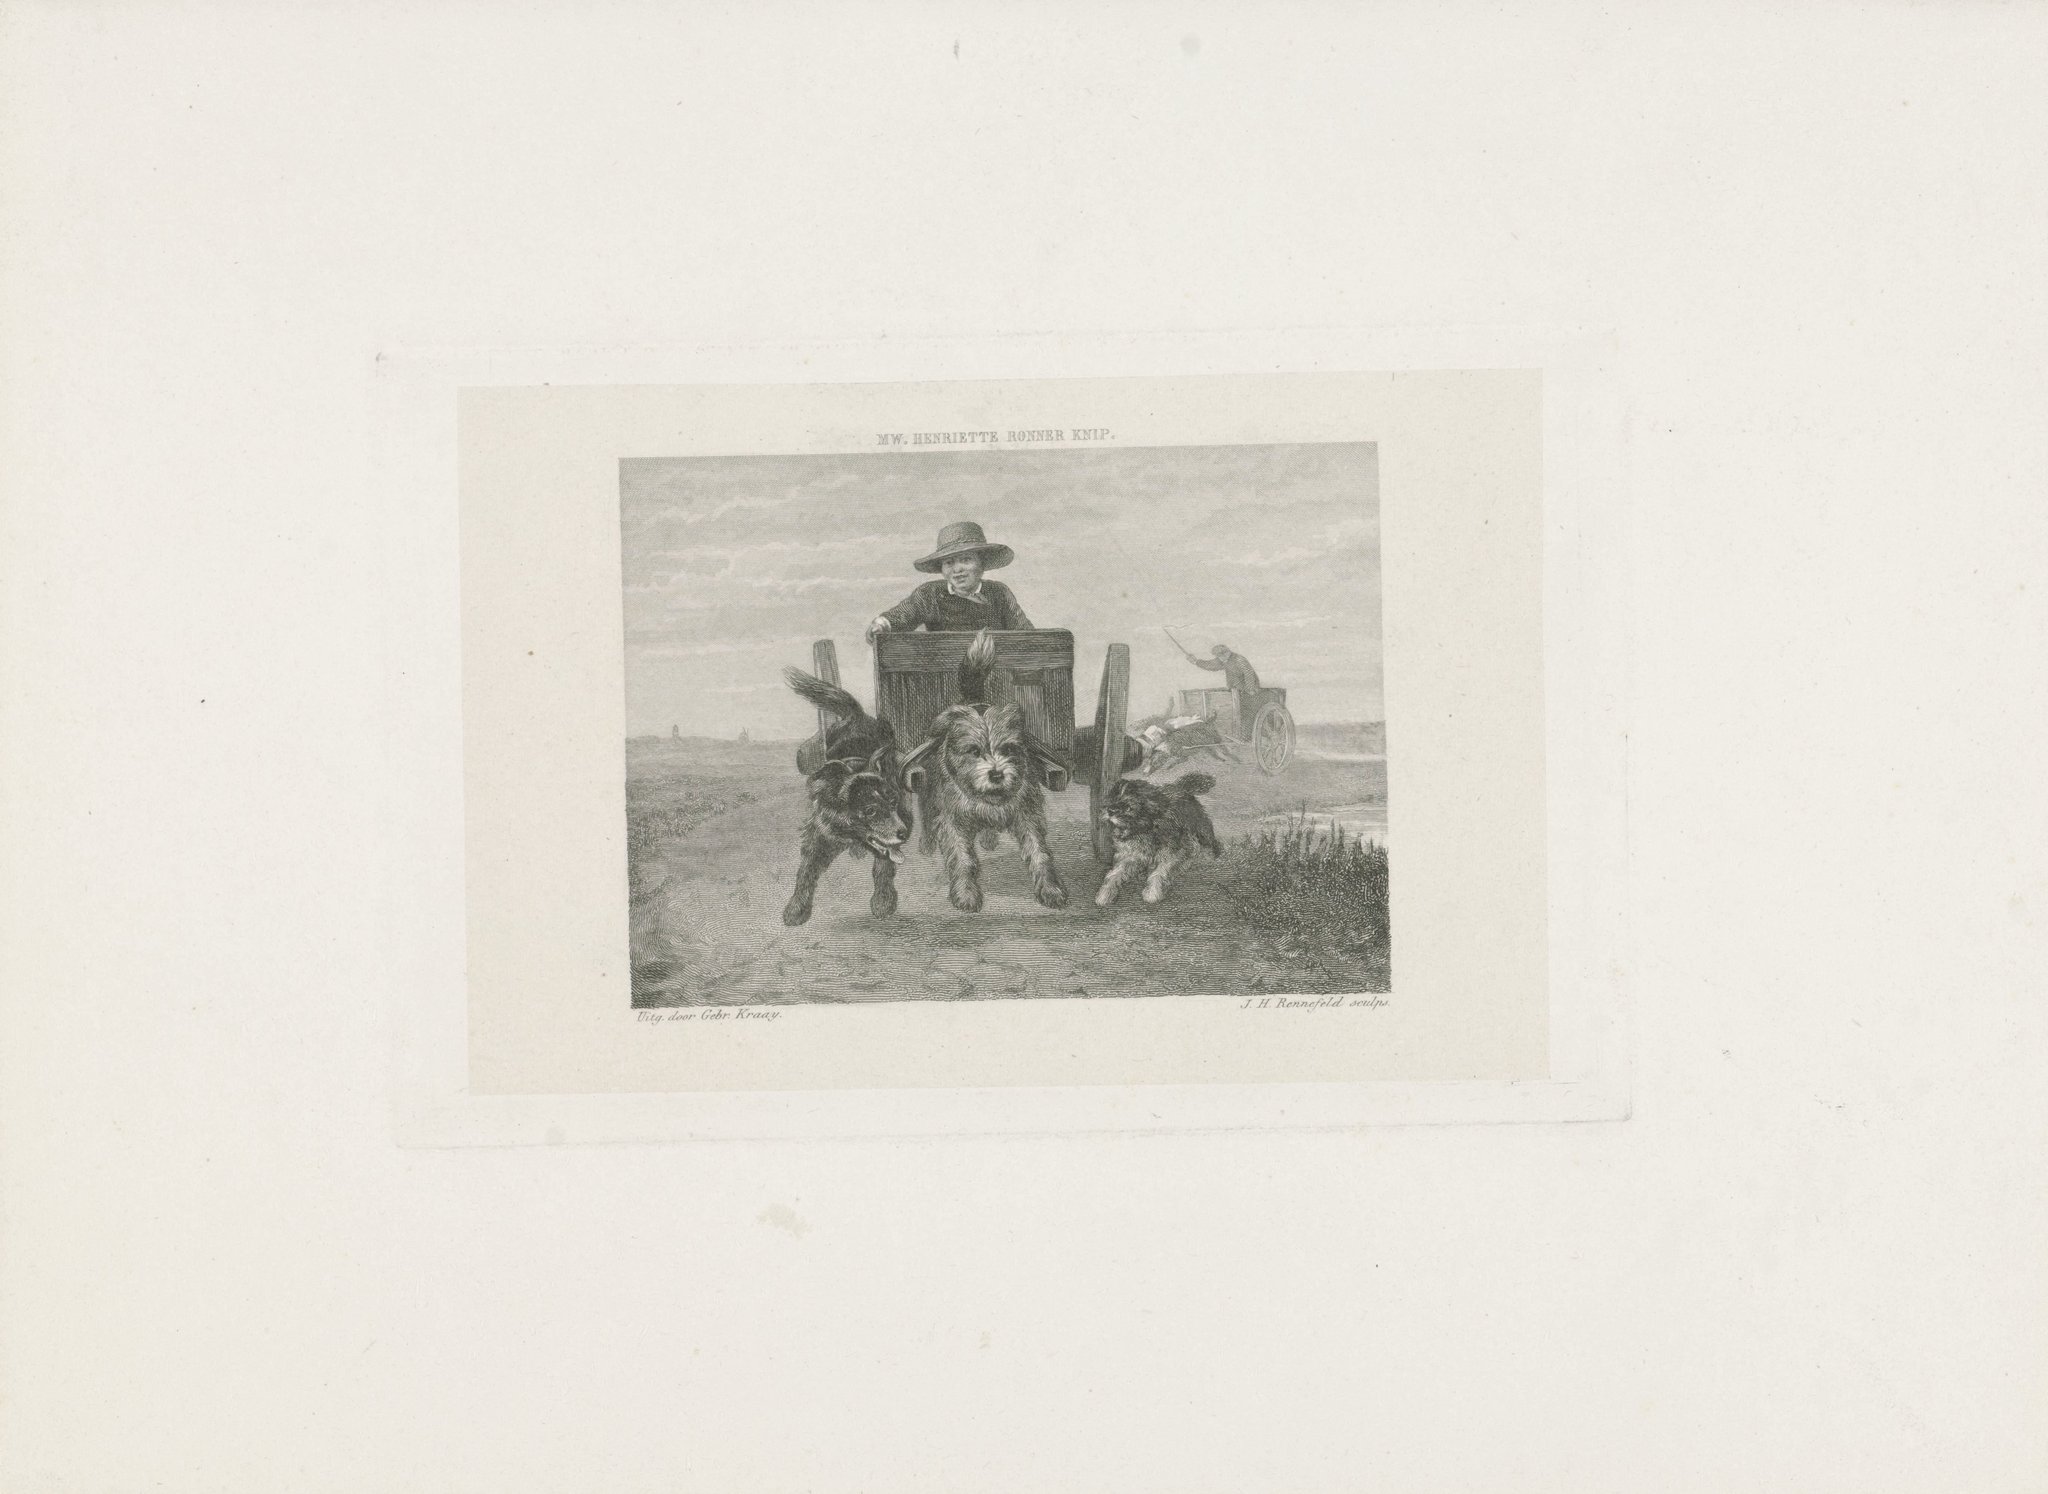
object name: print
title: Hondenkarren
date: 1845-1877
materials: paper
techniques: engraving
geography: amsterdam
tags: church (exterior), windmill, two-wheeled vehicle drawn by one animal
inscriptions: collector's mark: Lugt 2233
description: Een race tussen twee karren, voortgetrokken door honden, op een onverharde weg. Op de achtergrond de contouren van een molen en een kerk.